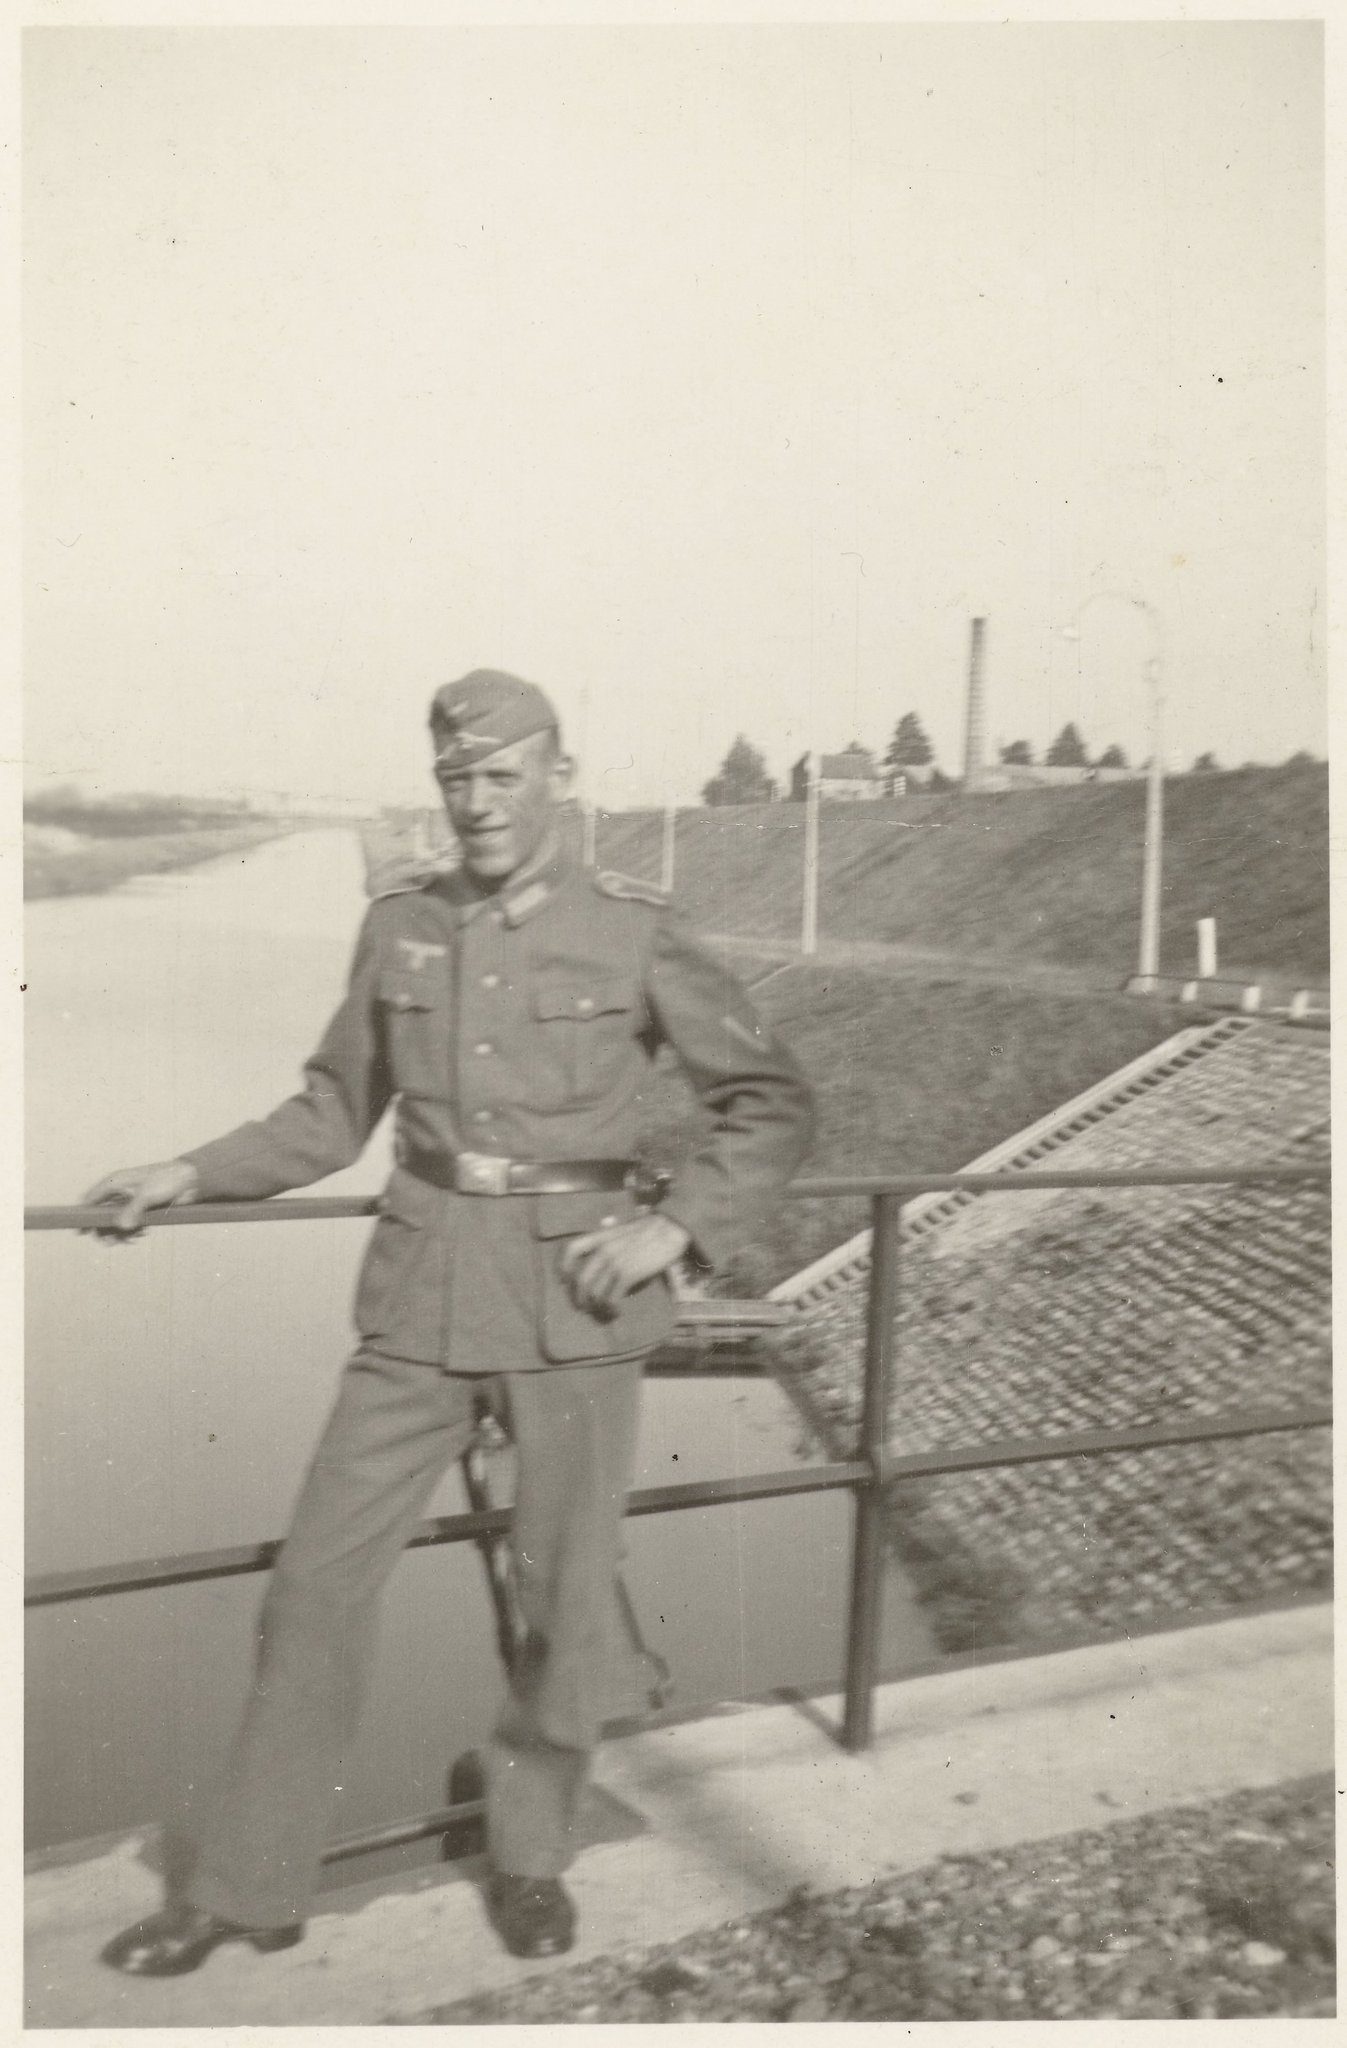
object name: photograph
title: Een Duitse Wehrmacht soldaat op een brug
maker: Anonymous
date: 1940-1945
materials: photographic support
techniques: gelatin silver print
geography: belgium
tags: germany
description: Een Duitse Wehrmacht soldaat poseert op een brug over een kanaal. Langs het kanaal een dijk. Foto behorend bij album 'Kriegserinnerungen'.